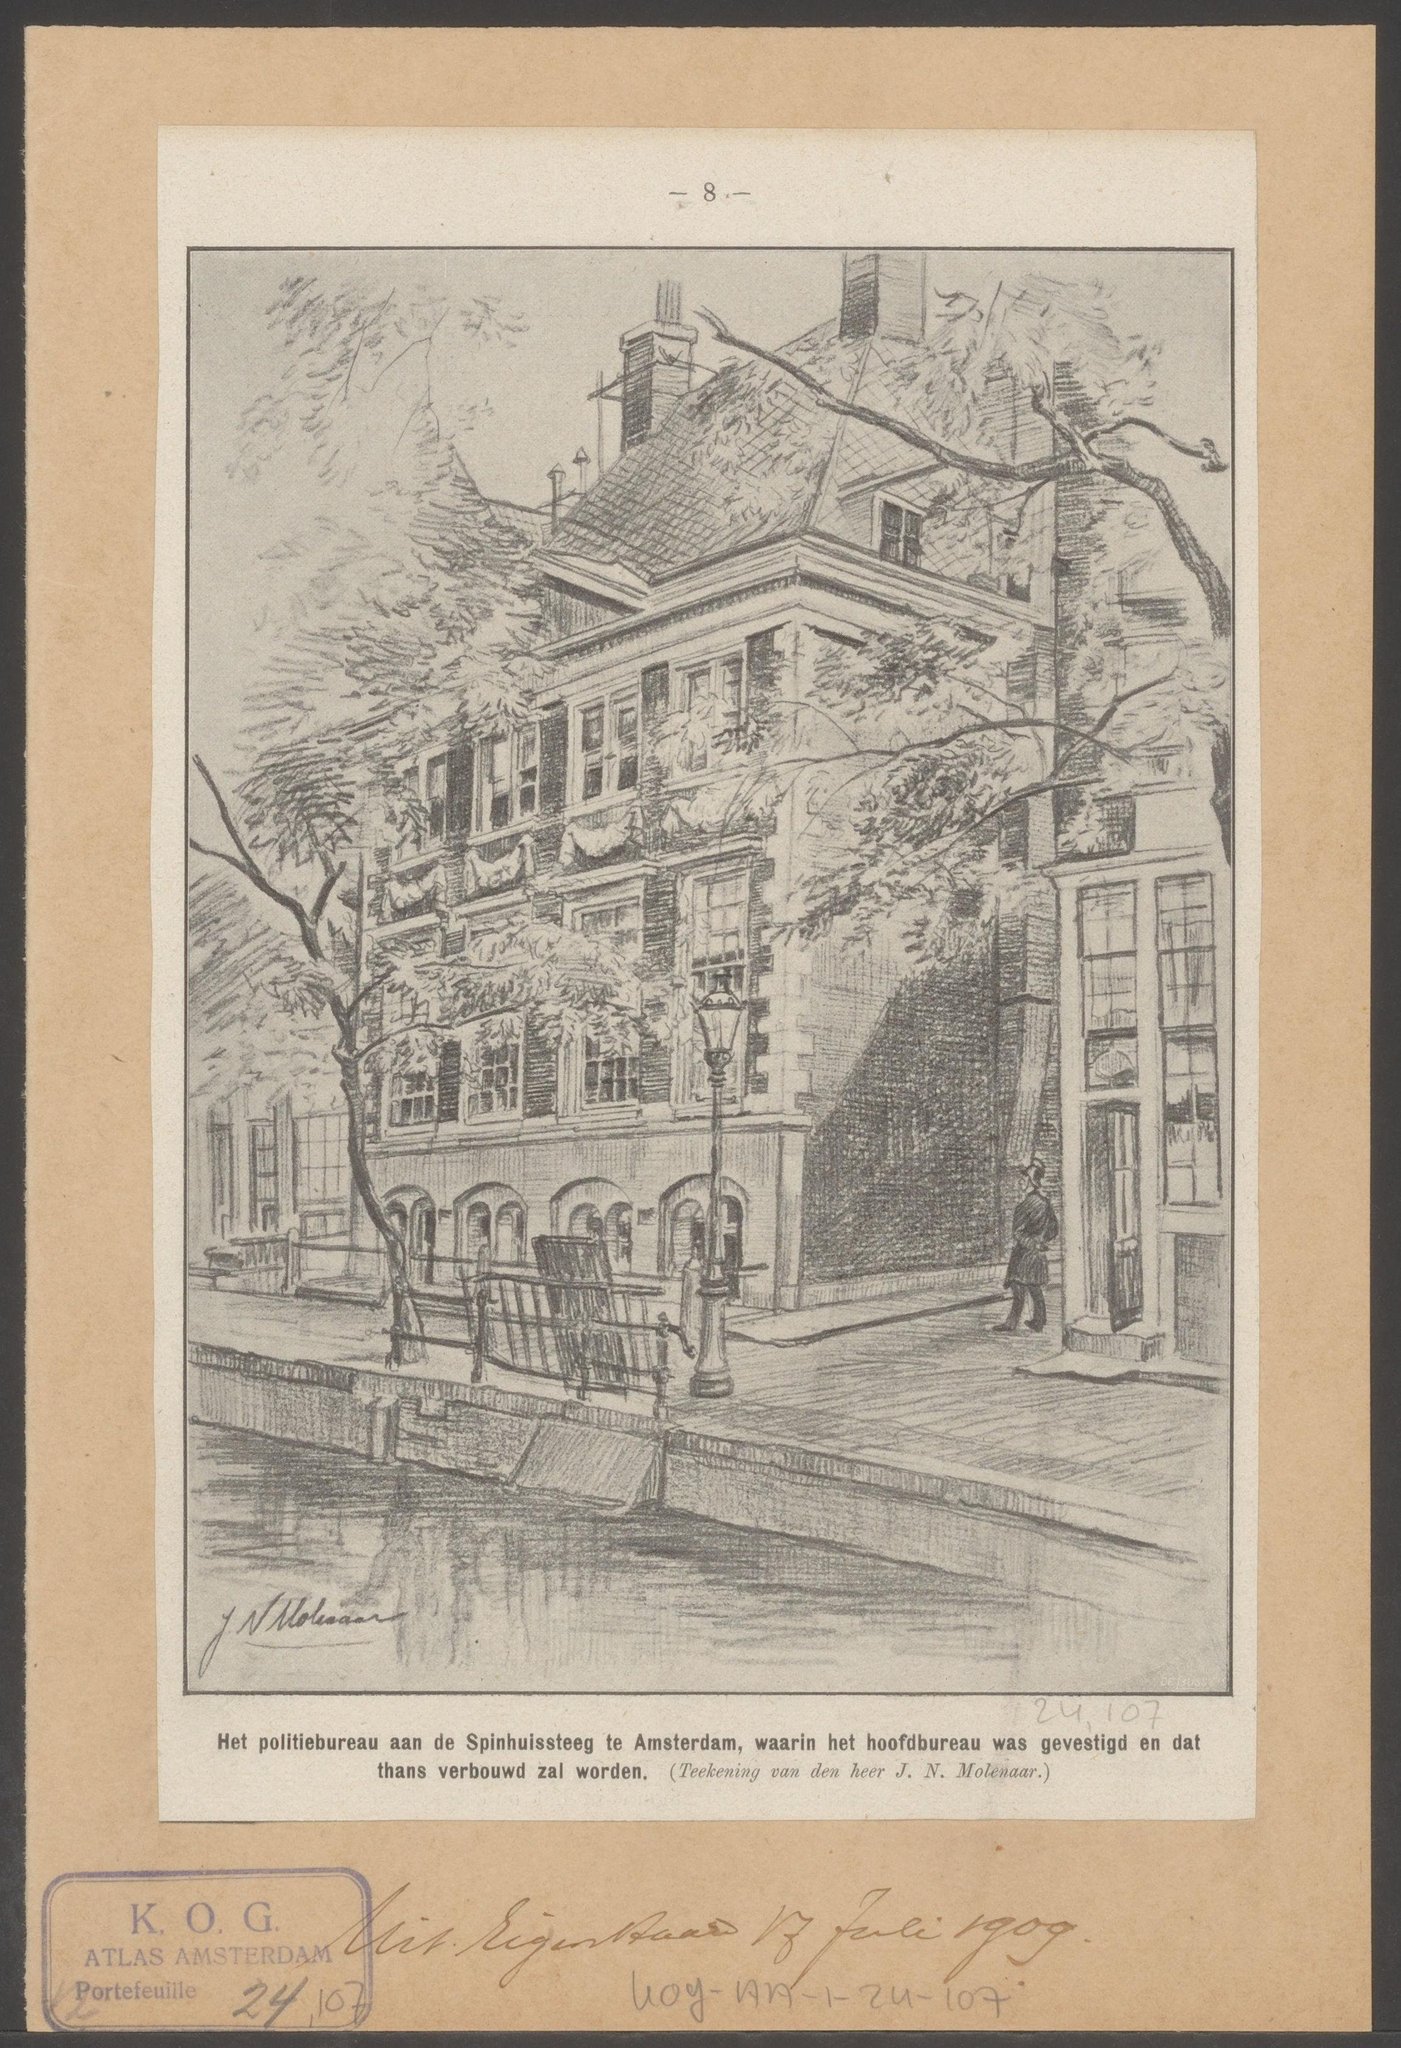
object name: photomechanical print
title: Gezicht op het politiebureau aan de Spinhuissteeg te Amsterdam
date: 1909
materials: paper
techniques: letterpress printing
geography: amsterdam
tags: policeman, constable, canals, waters (in city), civic architecture; edifices; dwellings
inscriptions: collector's mark: Lugt 1641b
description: Prent uit: Van Week tot Week (1909), 17 juli 1909, p. 8.